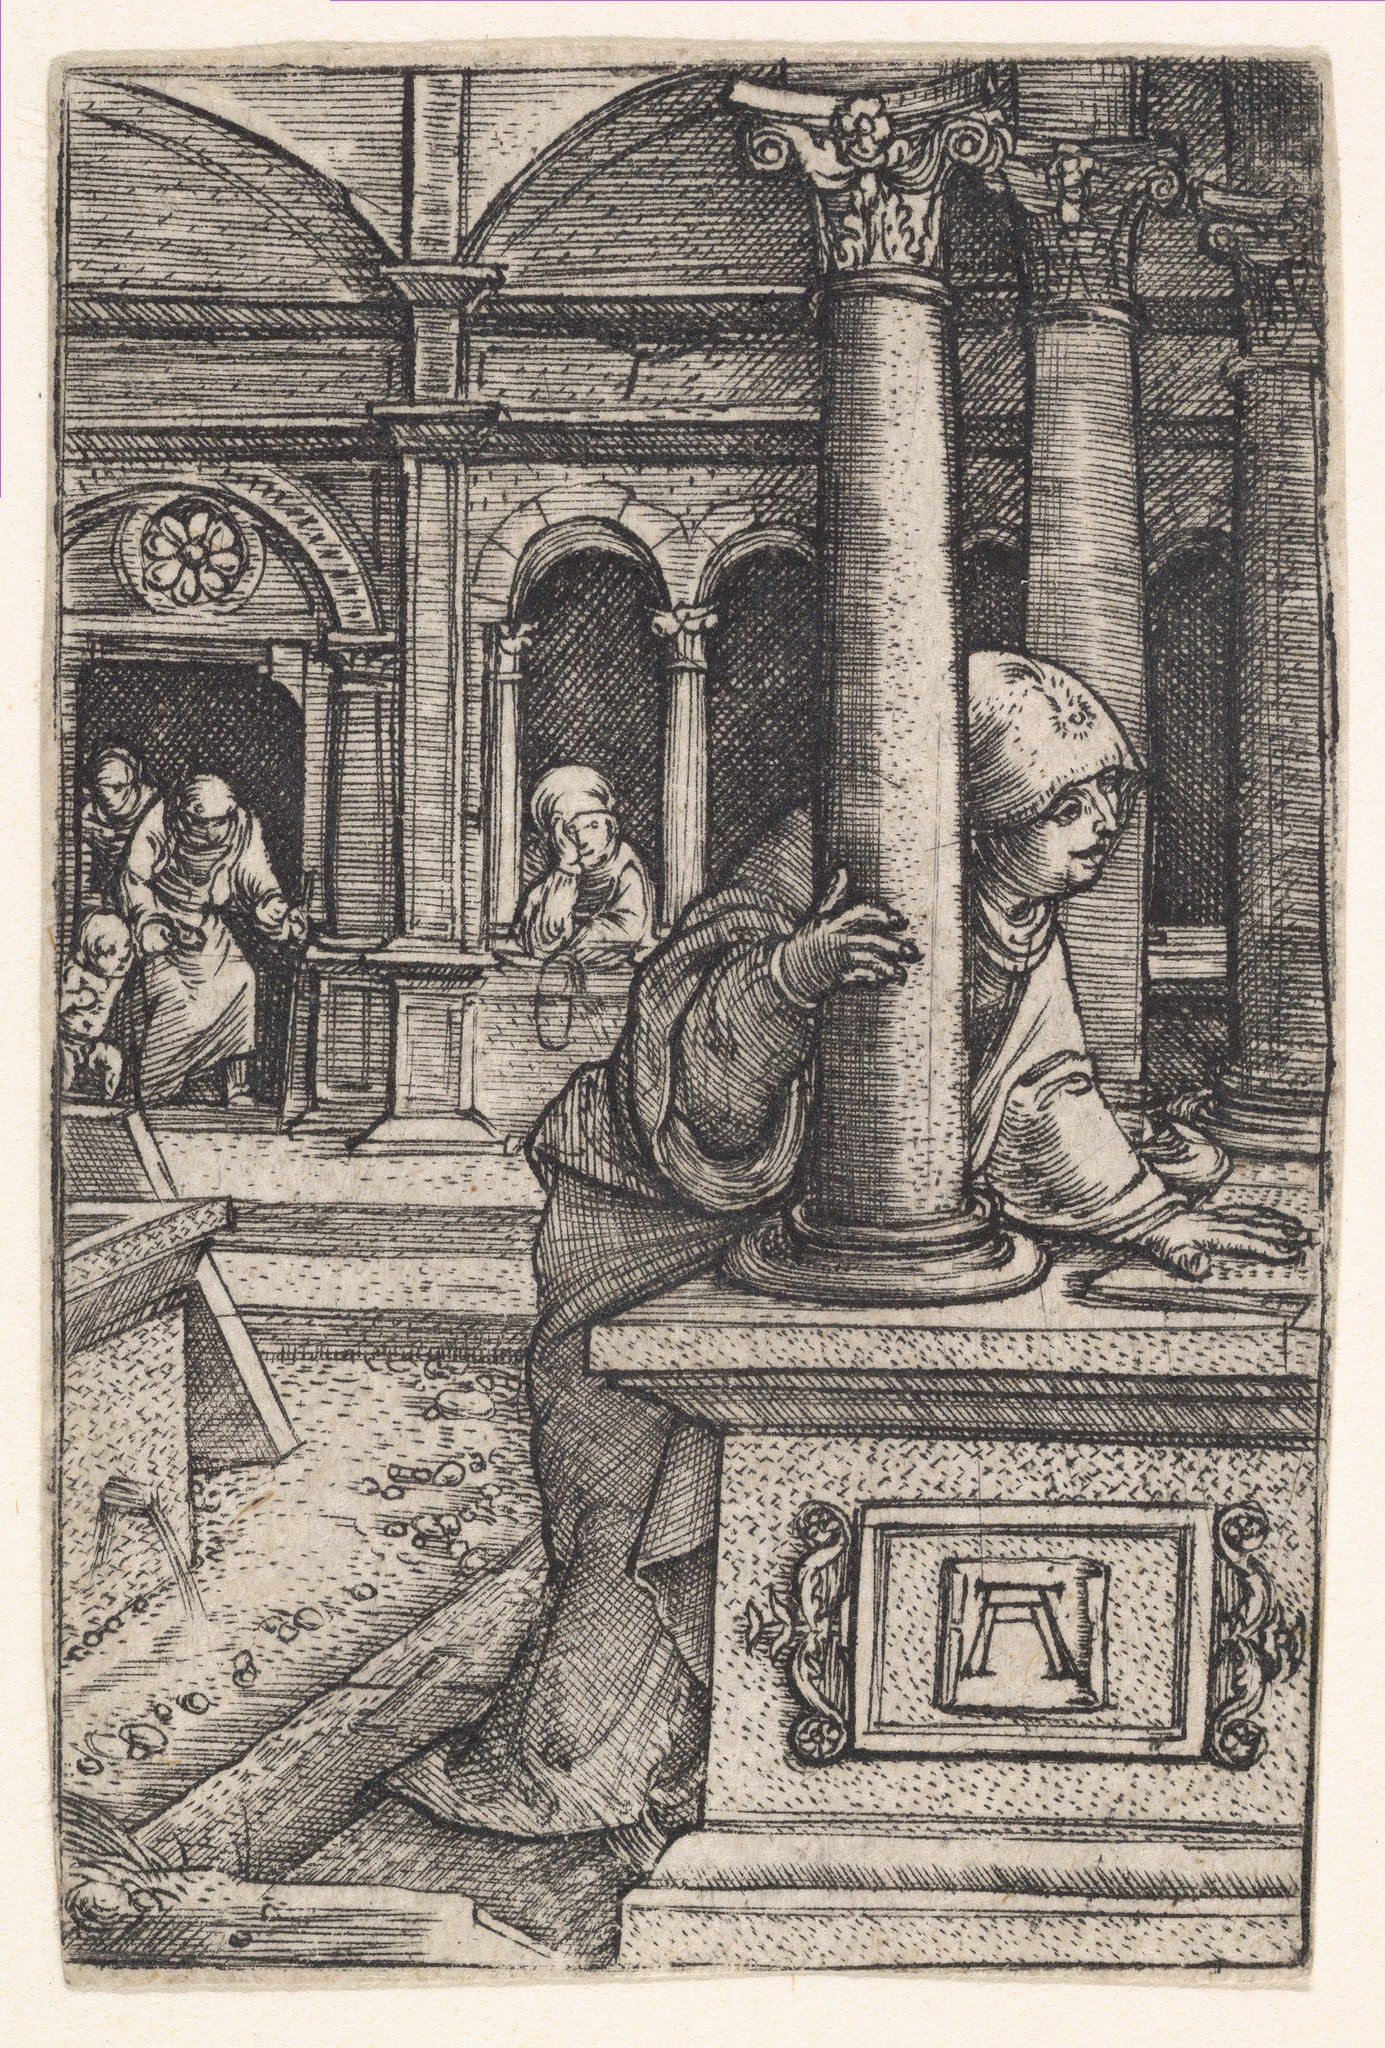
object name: print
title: The Virgin Searching For Her Son in the Temple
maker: albrecht altdorfer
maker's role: artist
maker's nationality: german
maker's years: 1480-1538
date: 1475-1538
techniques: engraving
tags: temples,children,women,virgin mary